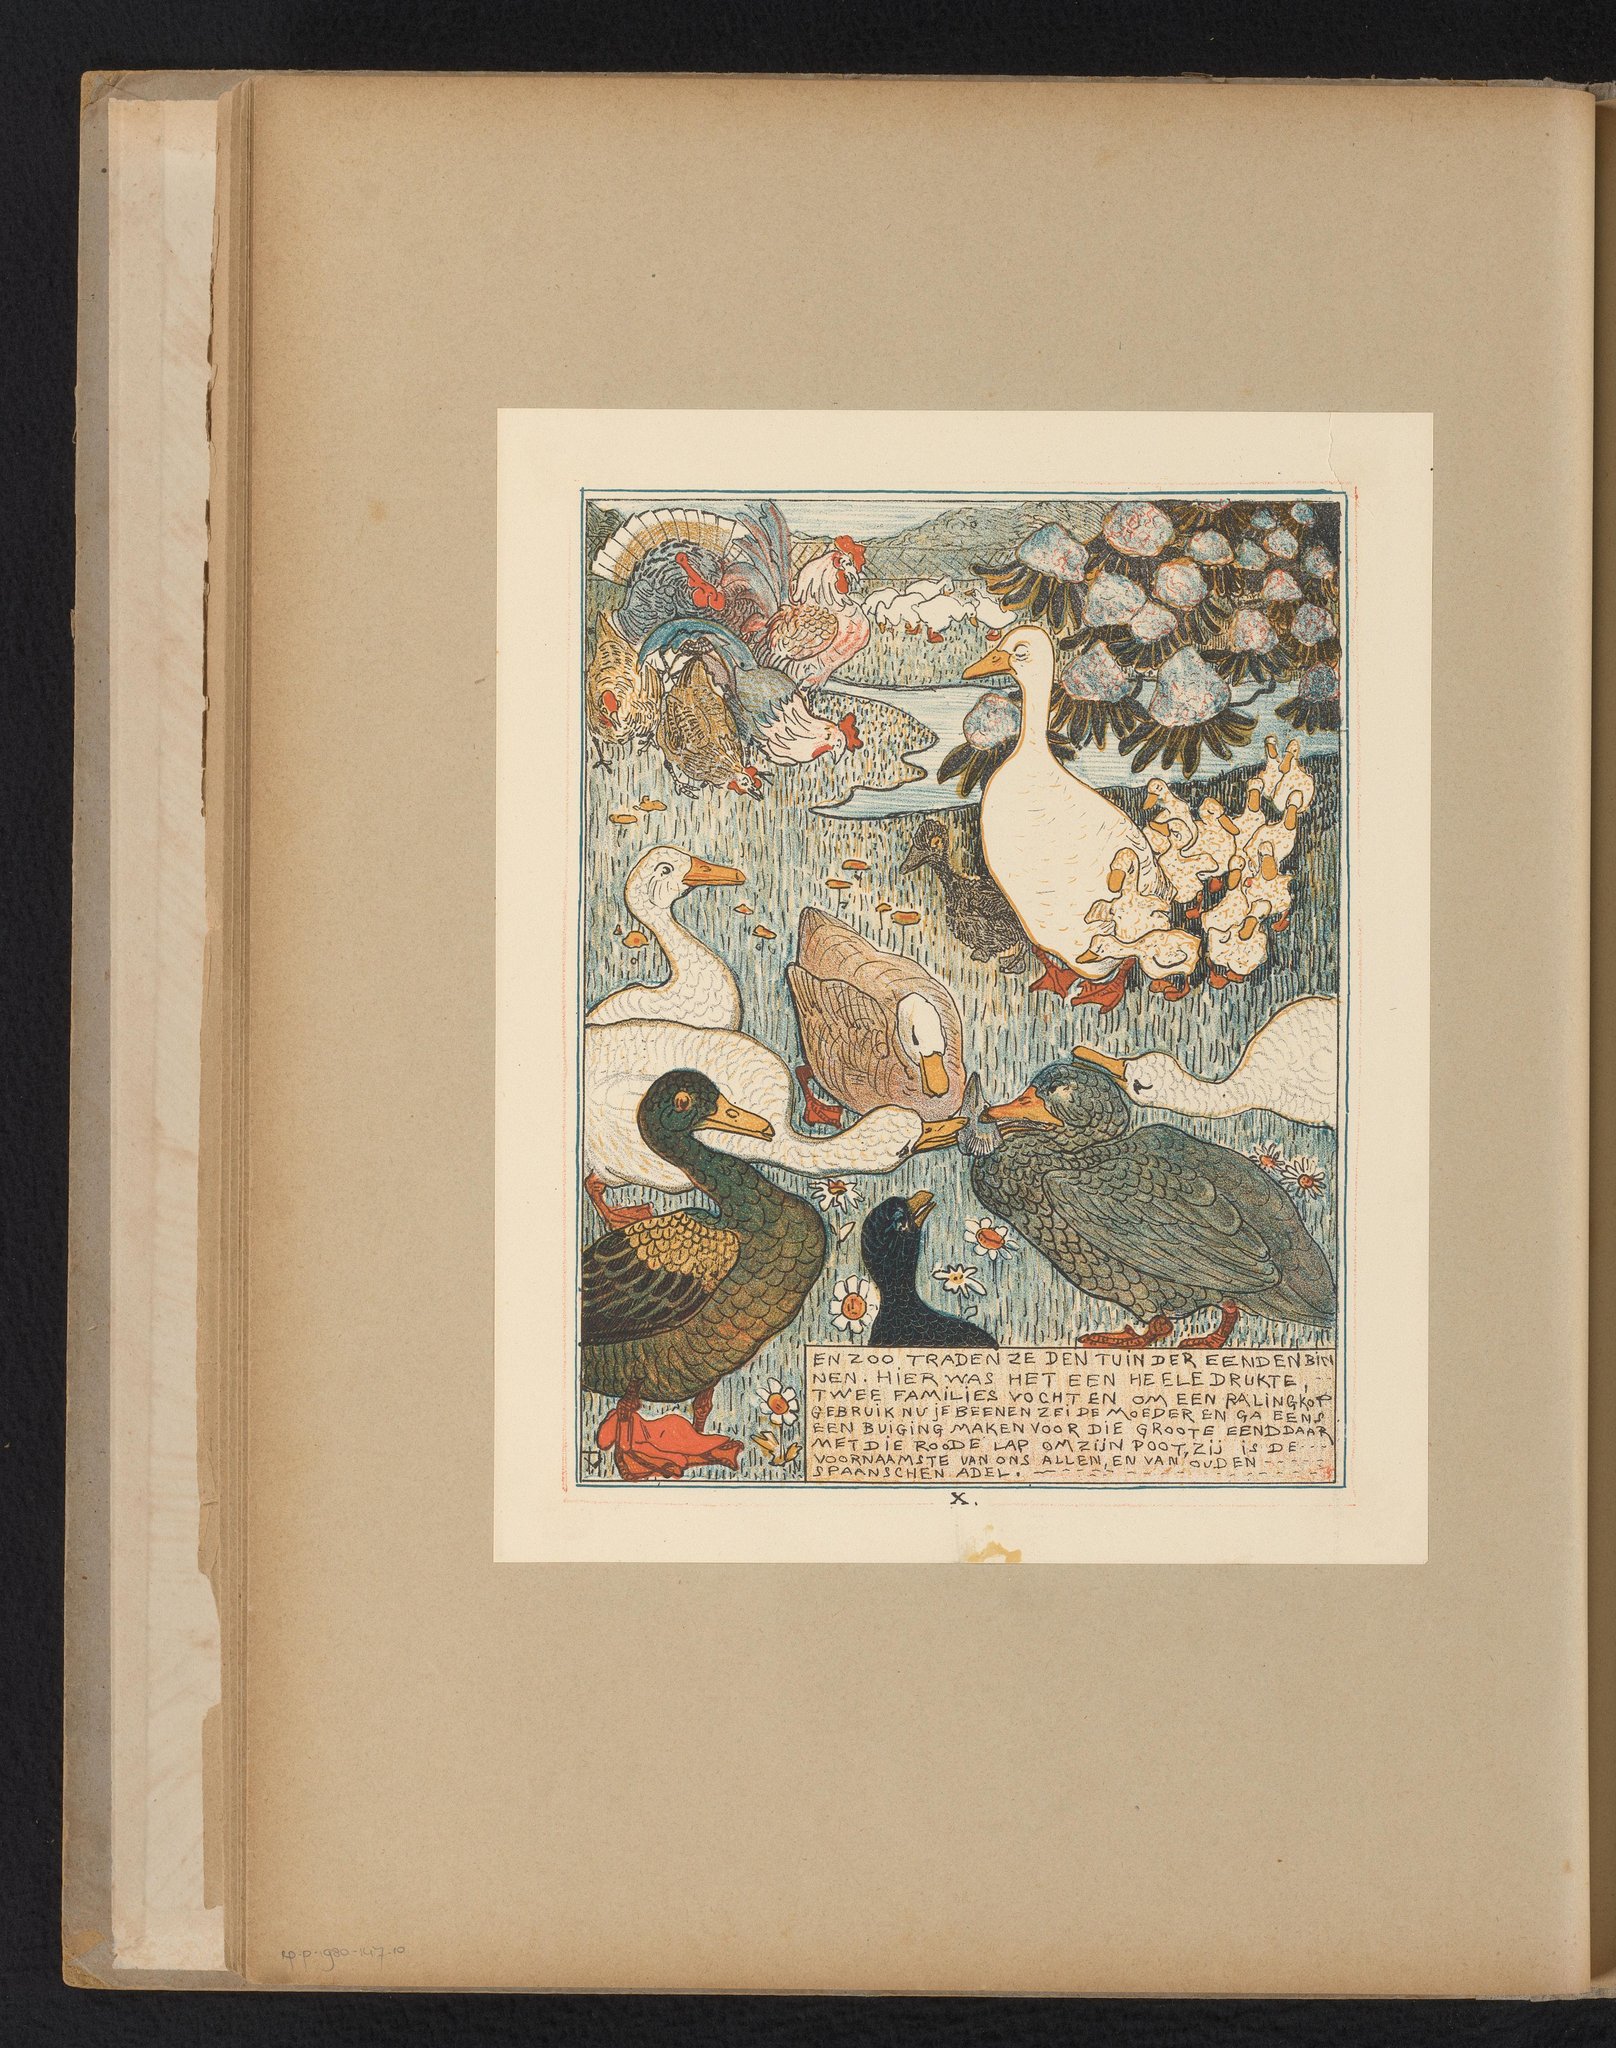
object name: album leaf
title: Moedereend brengt haar jongen naar de eendentuin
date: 1893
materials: paper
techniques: lithograph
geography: amsterdam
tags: fowl (cock, hen, chicken, etc.), water-birds: duck, walker and runner birds: turkey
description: Groep eenden, kippen en een kalkoen. Deze prent maakt deel uit van een album.